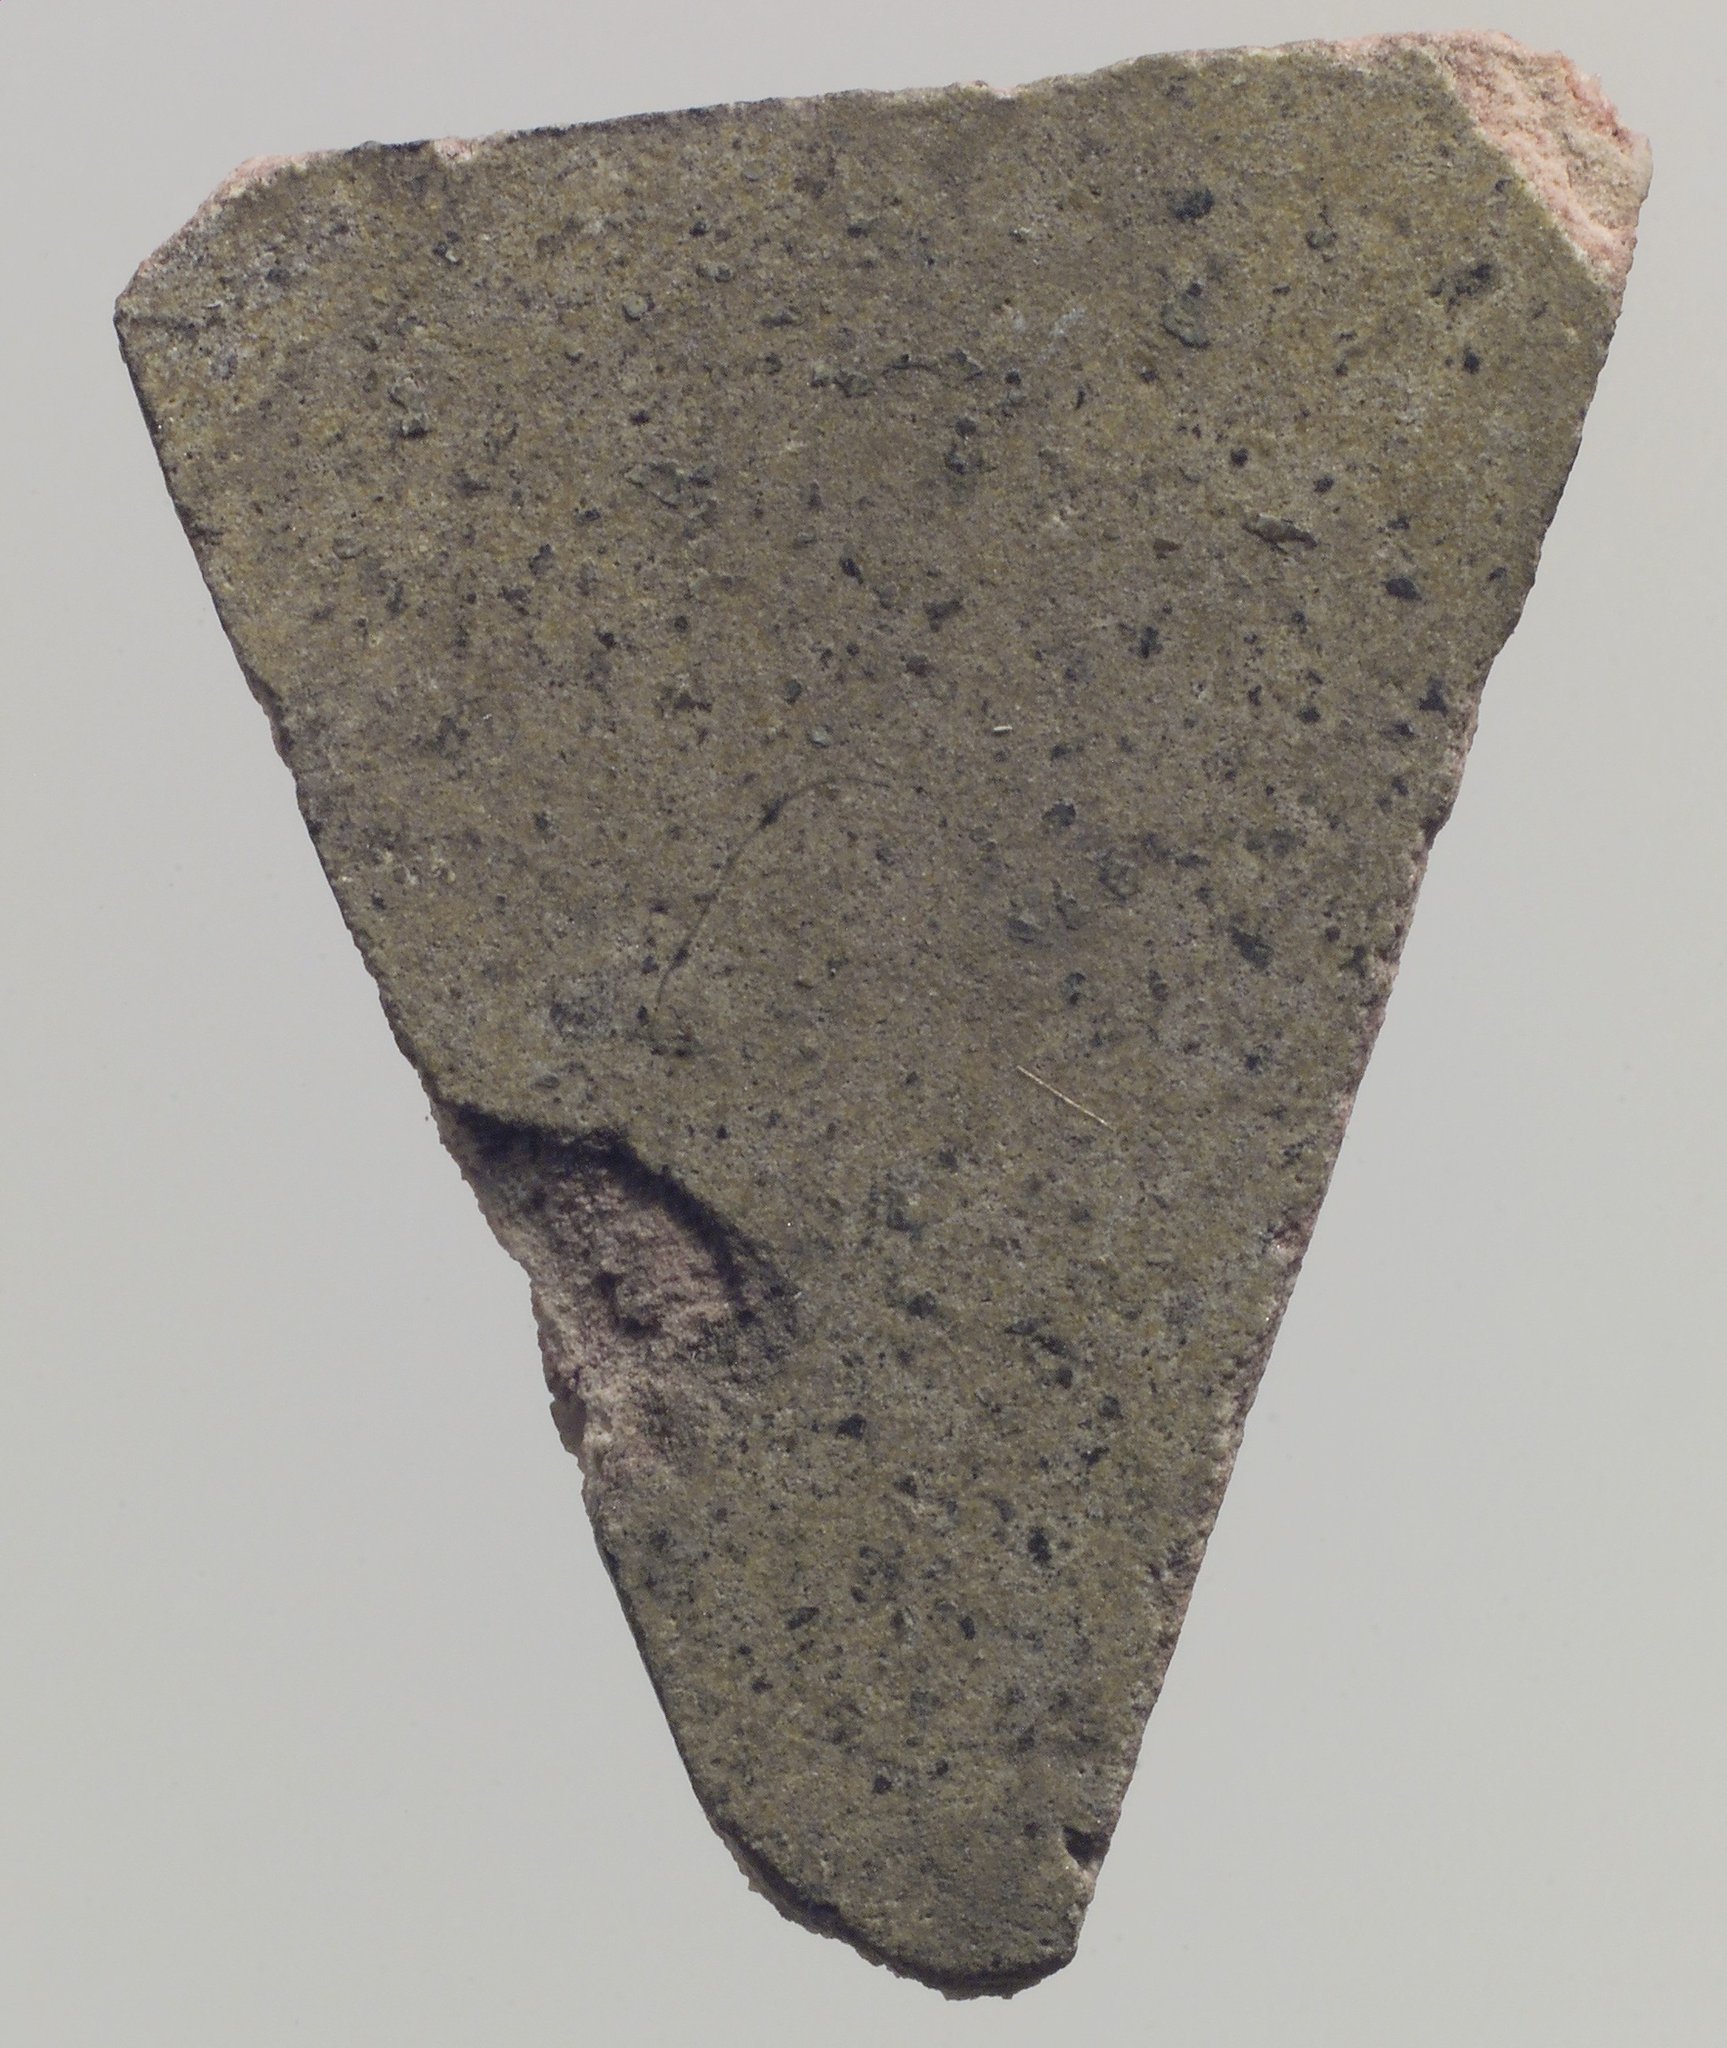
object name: furniture element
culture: assyrian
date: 1800-1701 BCE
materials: ivory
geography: anatolia